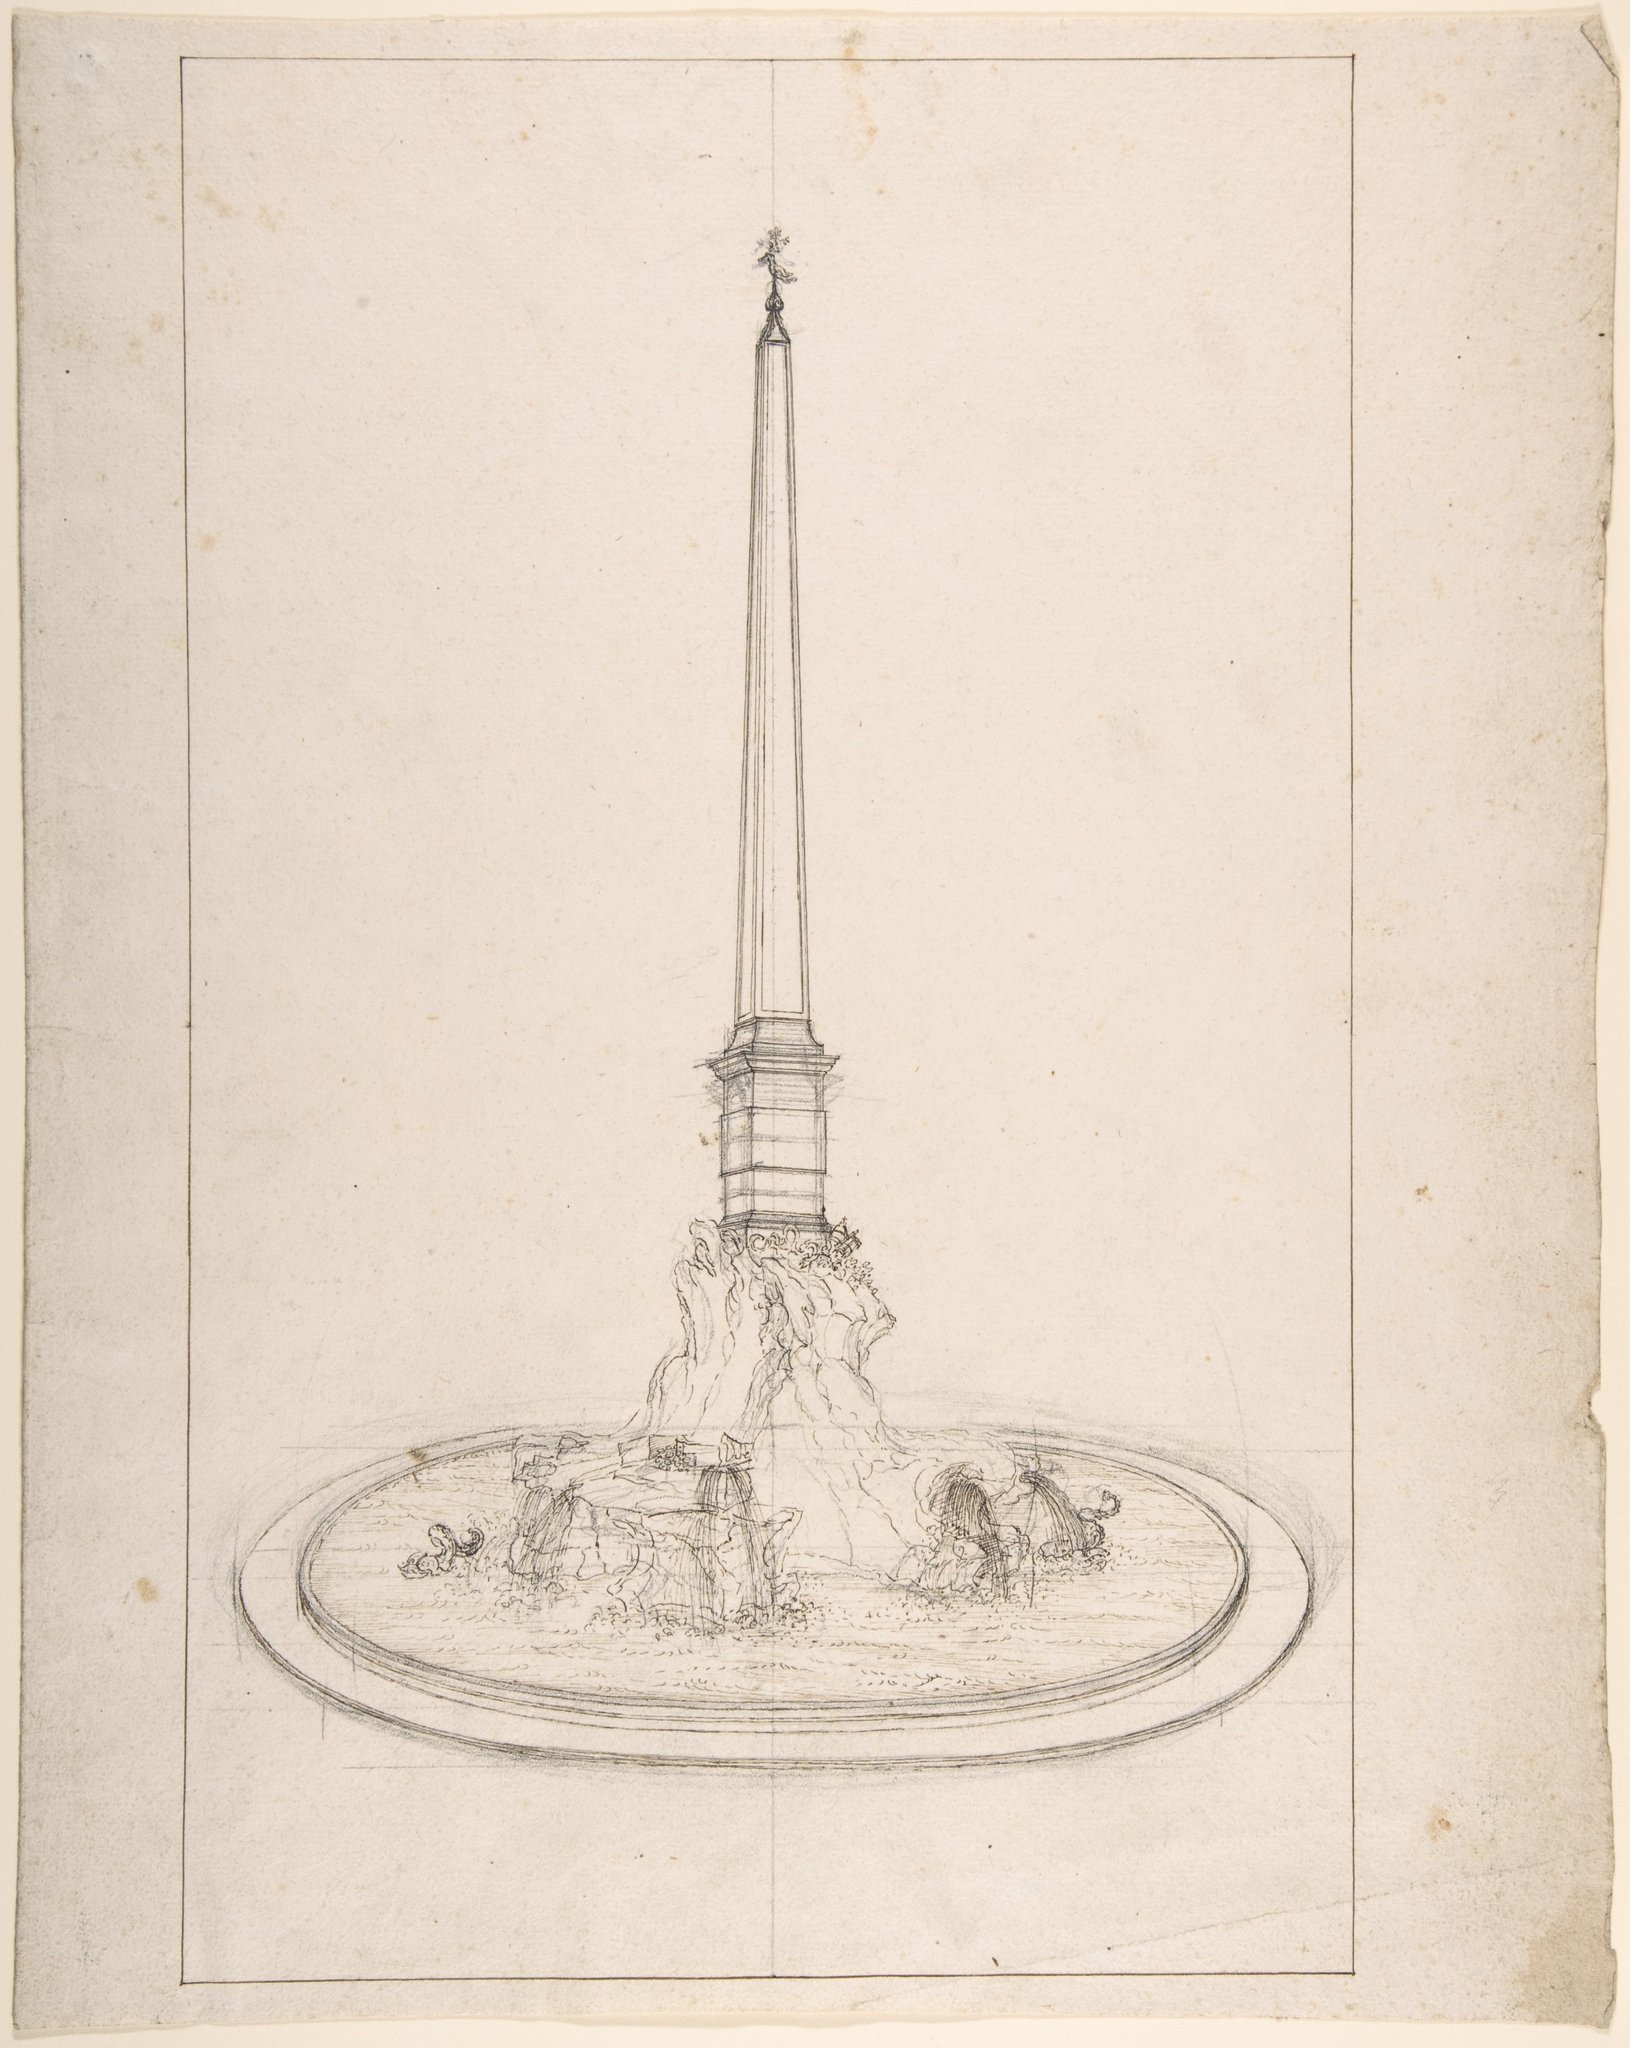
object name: drawing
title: Fountain with Obelisk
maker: anonymous, italian, 18th to 19th century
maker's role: artist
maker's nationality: italian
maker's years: 1700-1900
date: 1701-1900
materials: graphite, ink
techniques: pen, drawing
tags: fountains,obelisks